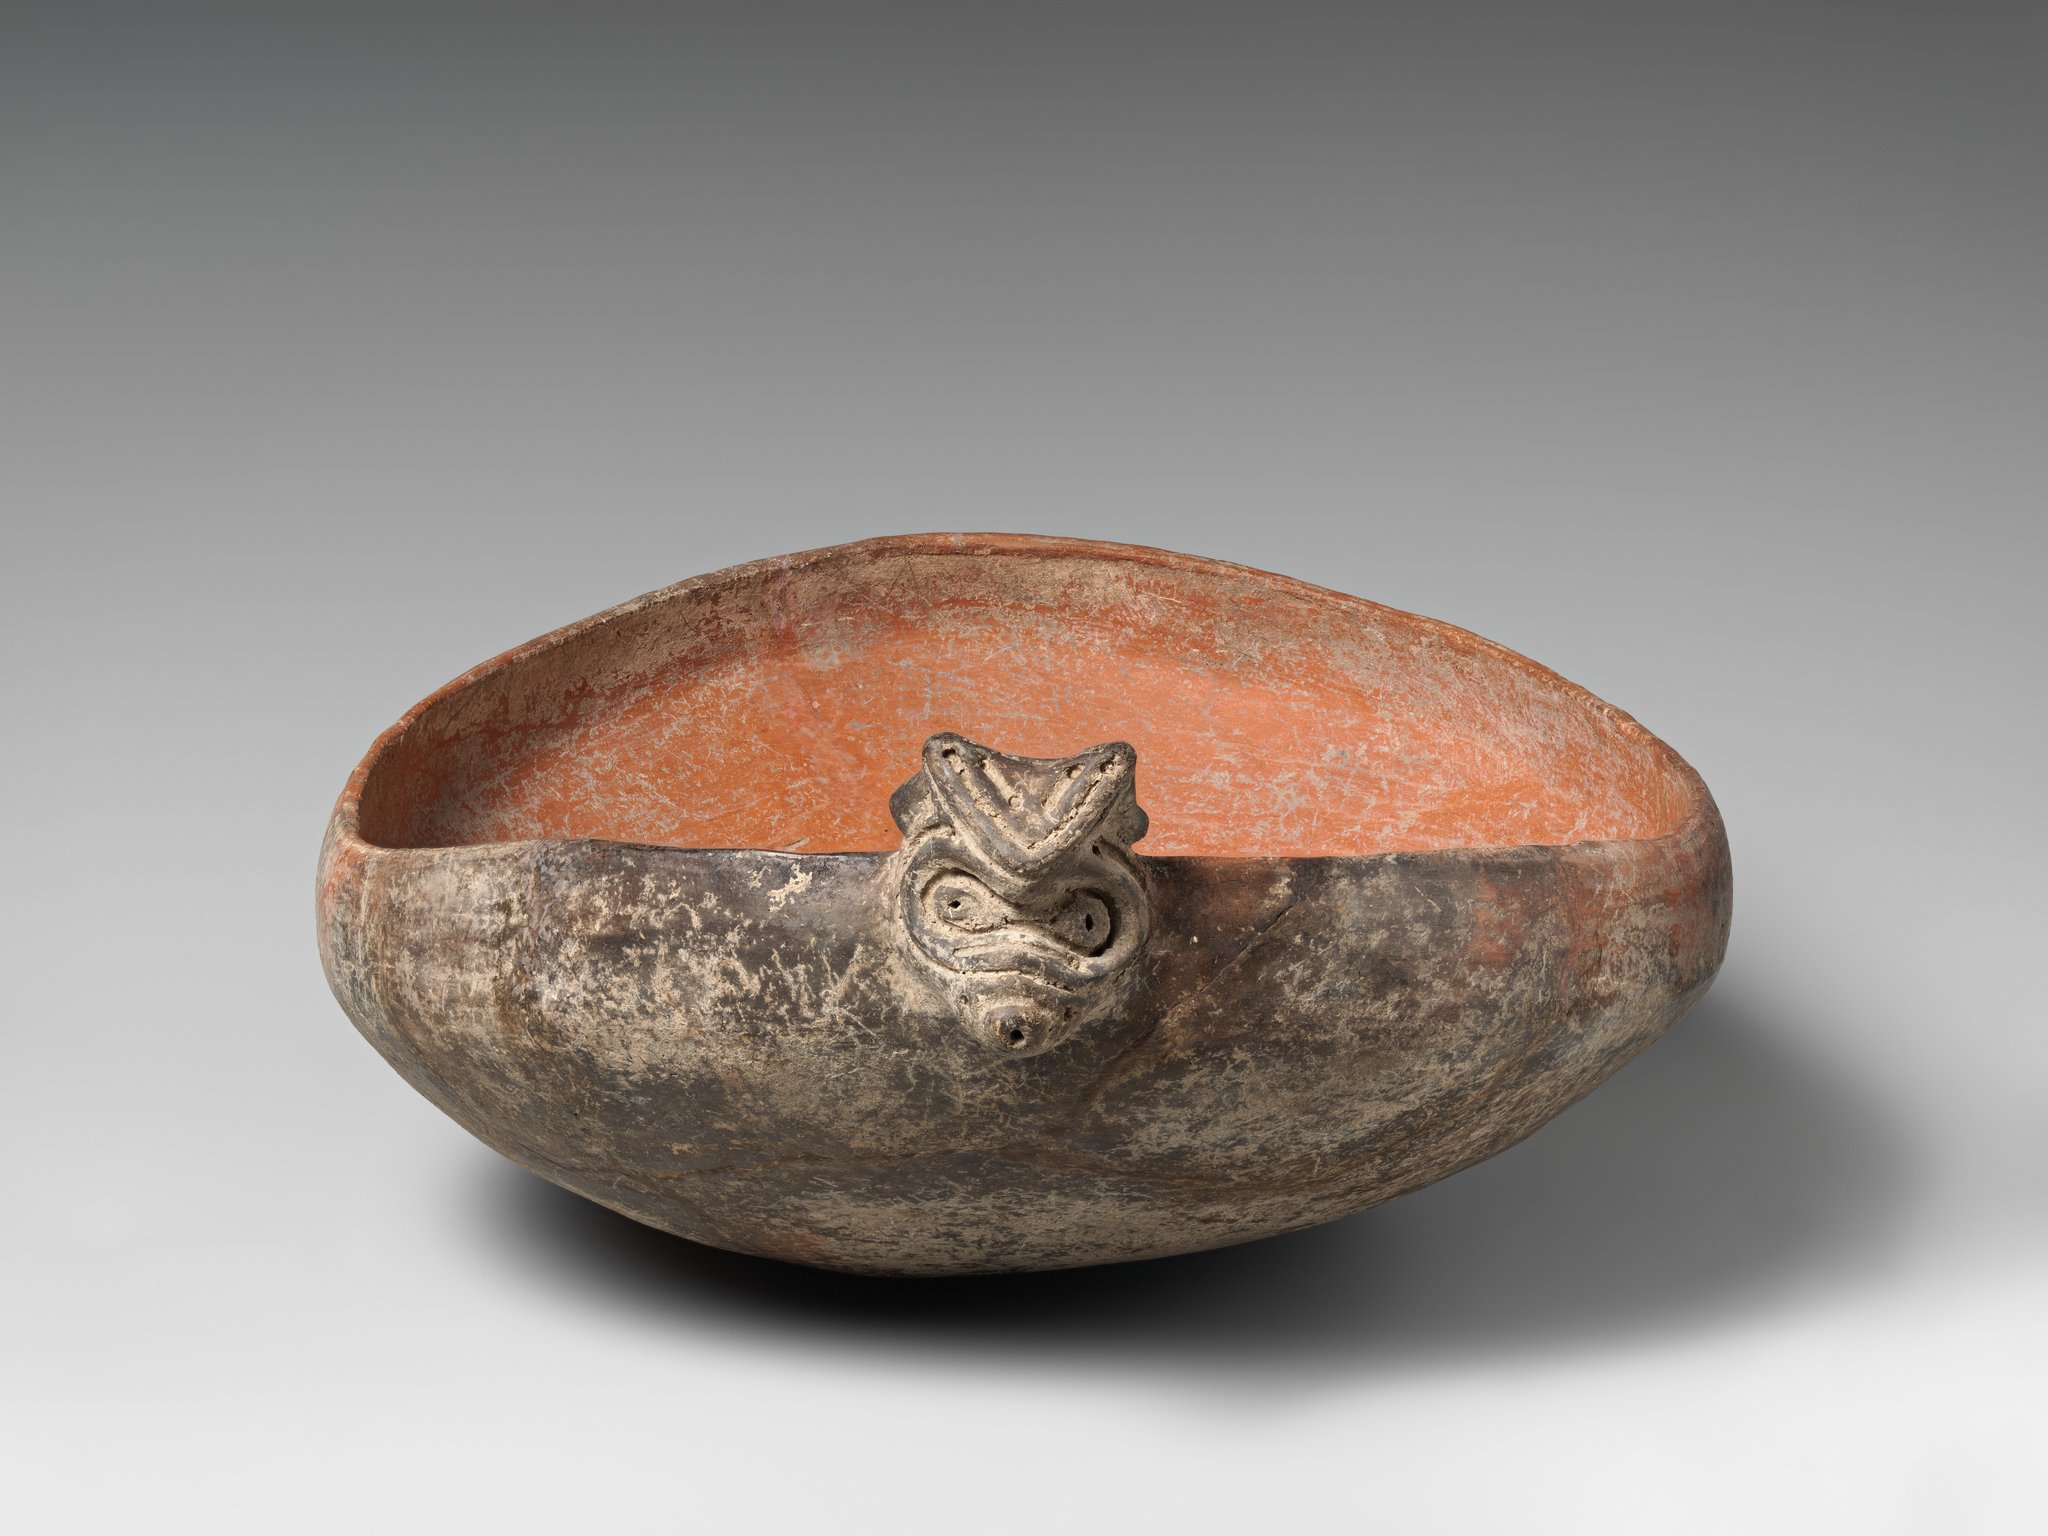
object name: bowl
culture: taíno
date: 1201-1500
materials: ceramic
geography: dominican republic